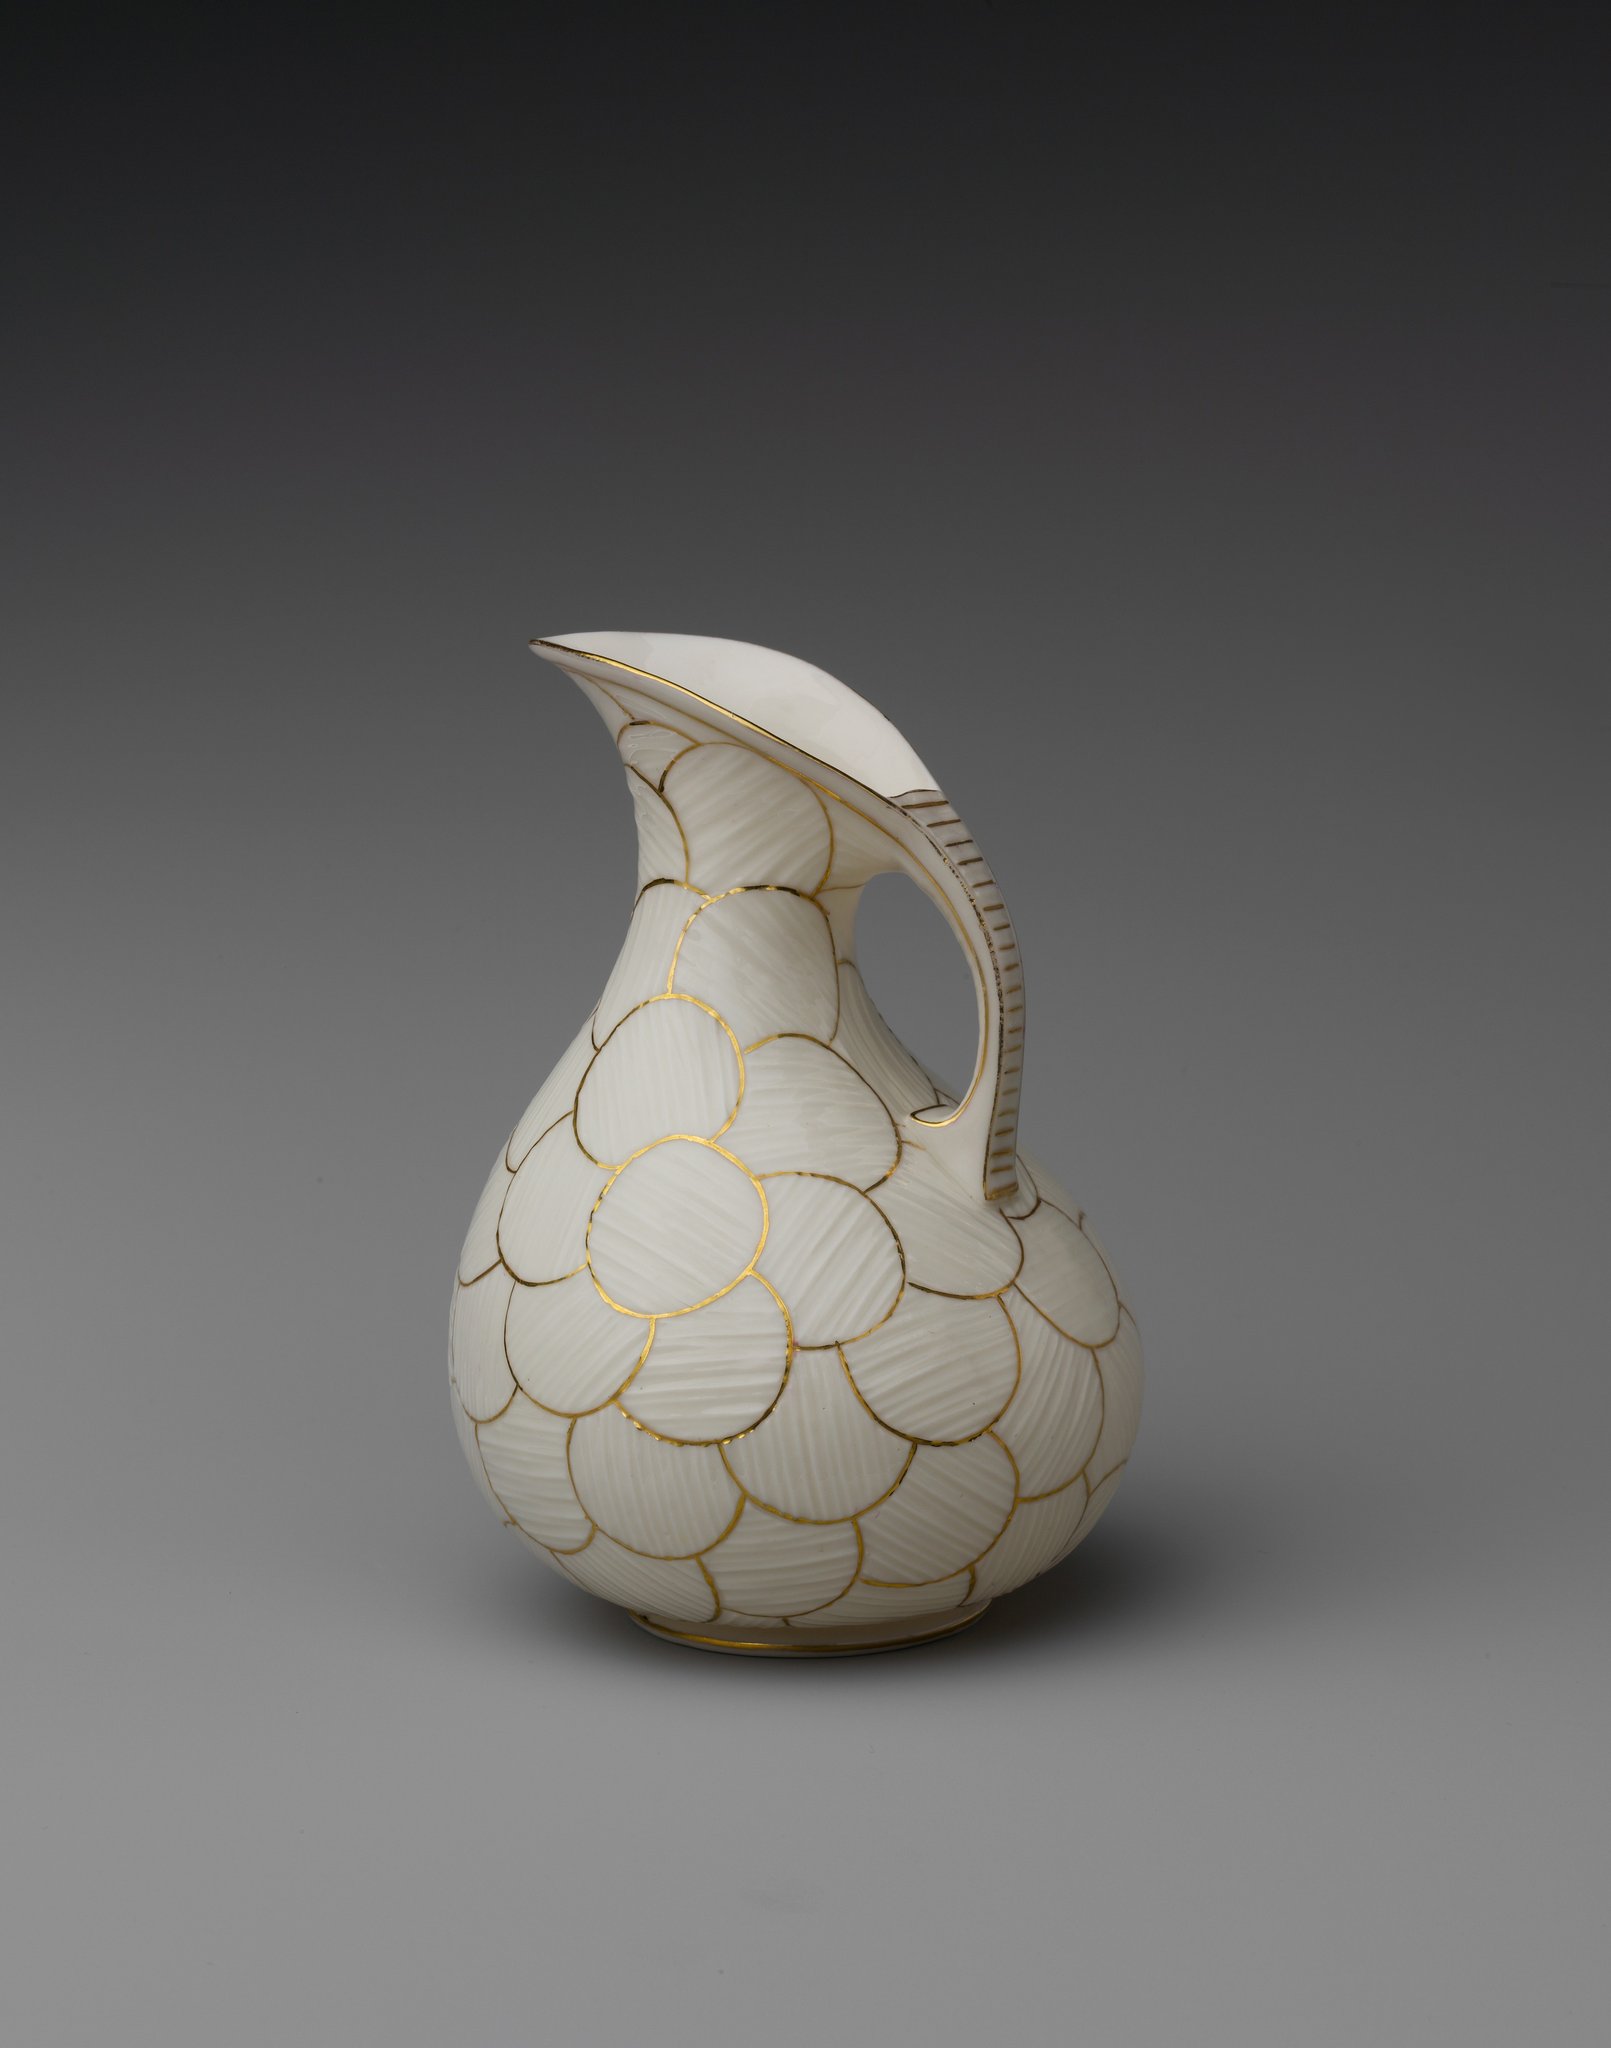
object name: pitcher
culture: american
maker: ott and brewer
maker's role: maker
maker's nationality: american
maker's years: 1871-1893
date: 1883-1890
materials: porcelain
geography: united states